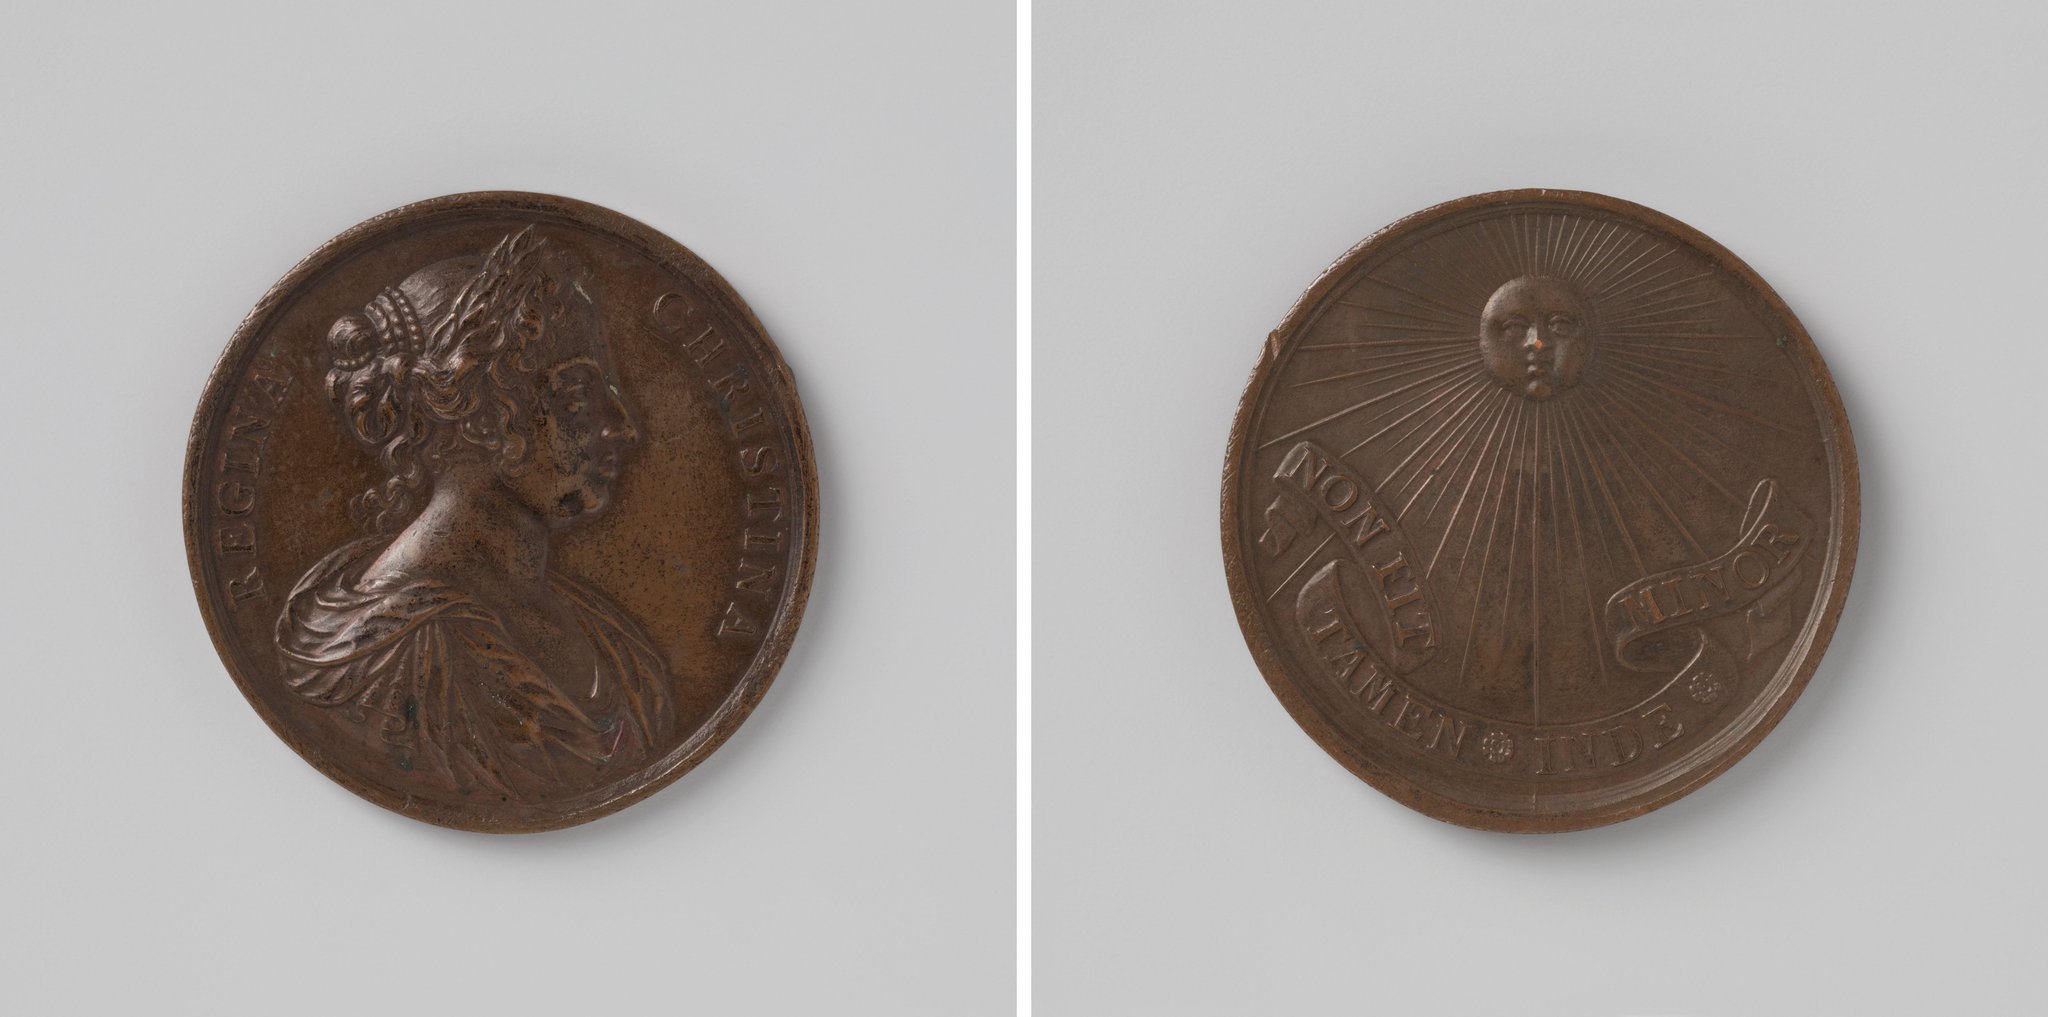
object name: history medal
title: Overgang van Christina van Zweden tot de Rooms Katholieke kerk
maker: Anonymous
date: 1654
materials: bronze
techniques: striking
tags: christina (koningin van zweden)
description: Bronzen penning. Voorzijde: borststuk vrouw met lauwerkrans binnen omschrift. Keerzijde: stralende zon boven wimpel met opschrift